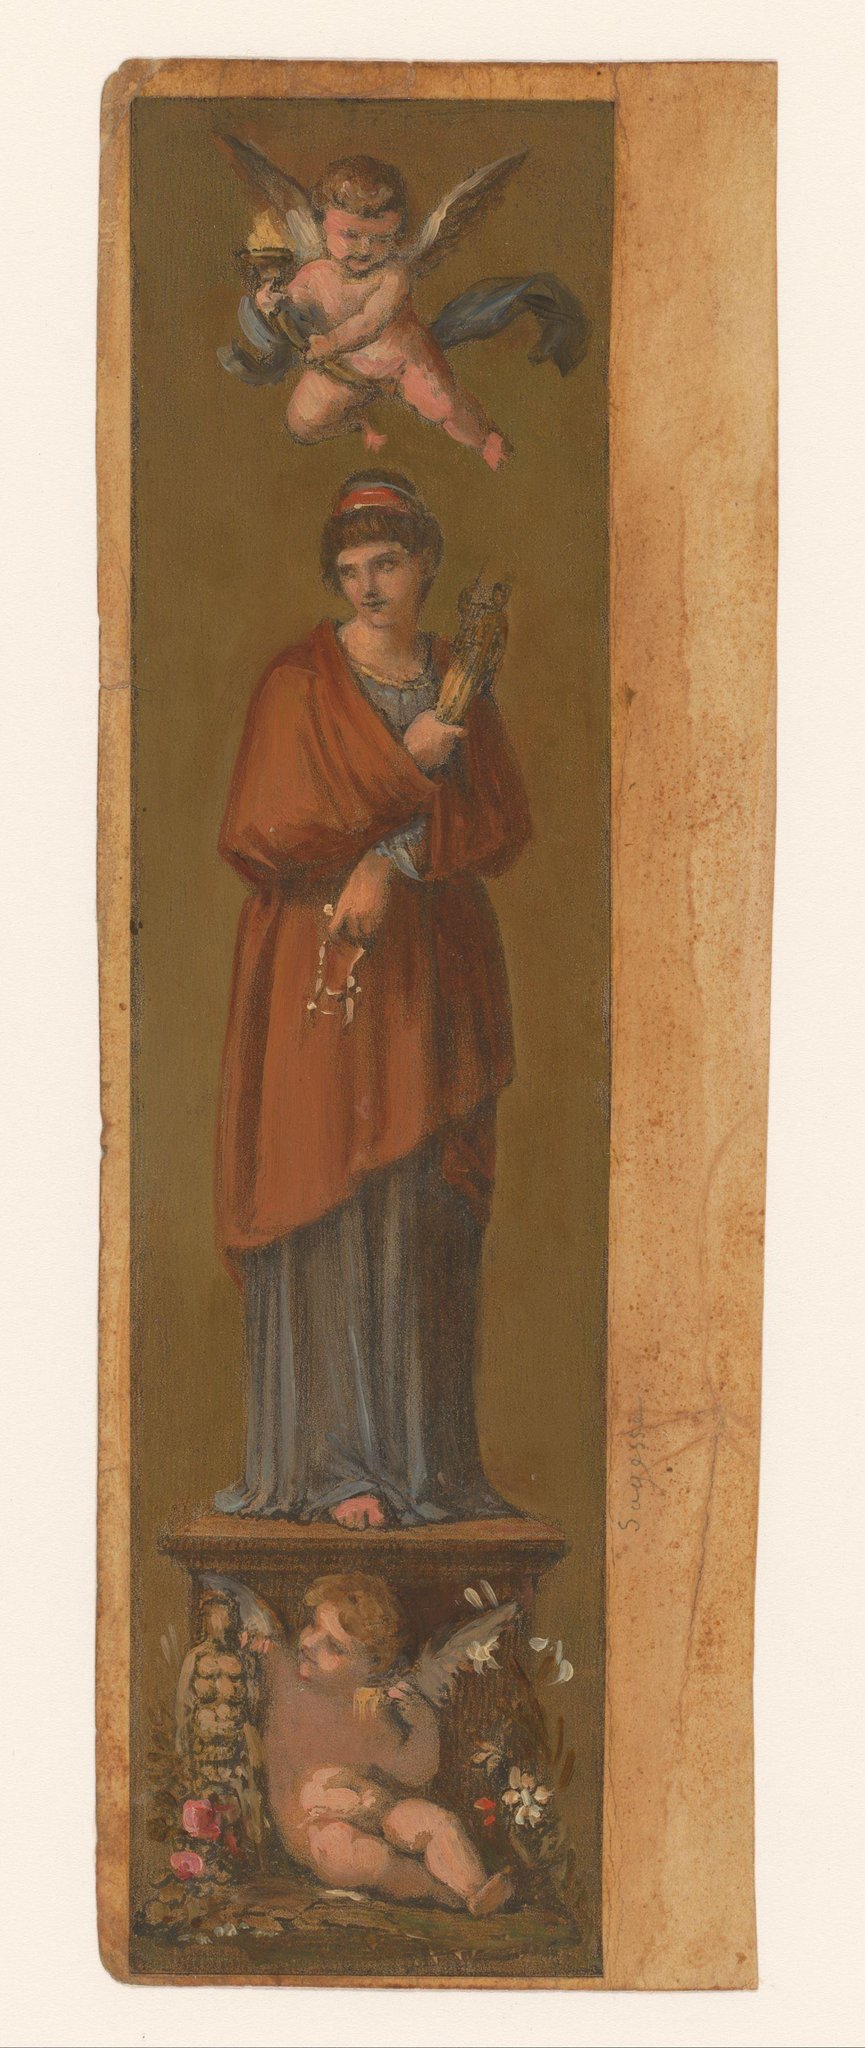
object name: print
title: Wijsheid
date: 1813-1874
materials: oil, paint, paper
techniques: lithograph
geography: paris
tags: wisdom; 'sapienza', 'sapienza humana', 'sapienza vera' (ripa), cupids: 'amores', 'amoretti', 'putti'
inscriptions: collector's mark: Lugt 2760, collector's mark: Lugt 2228